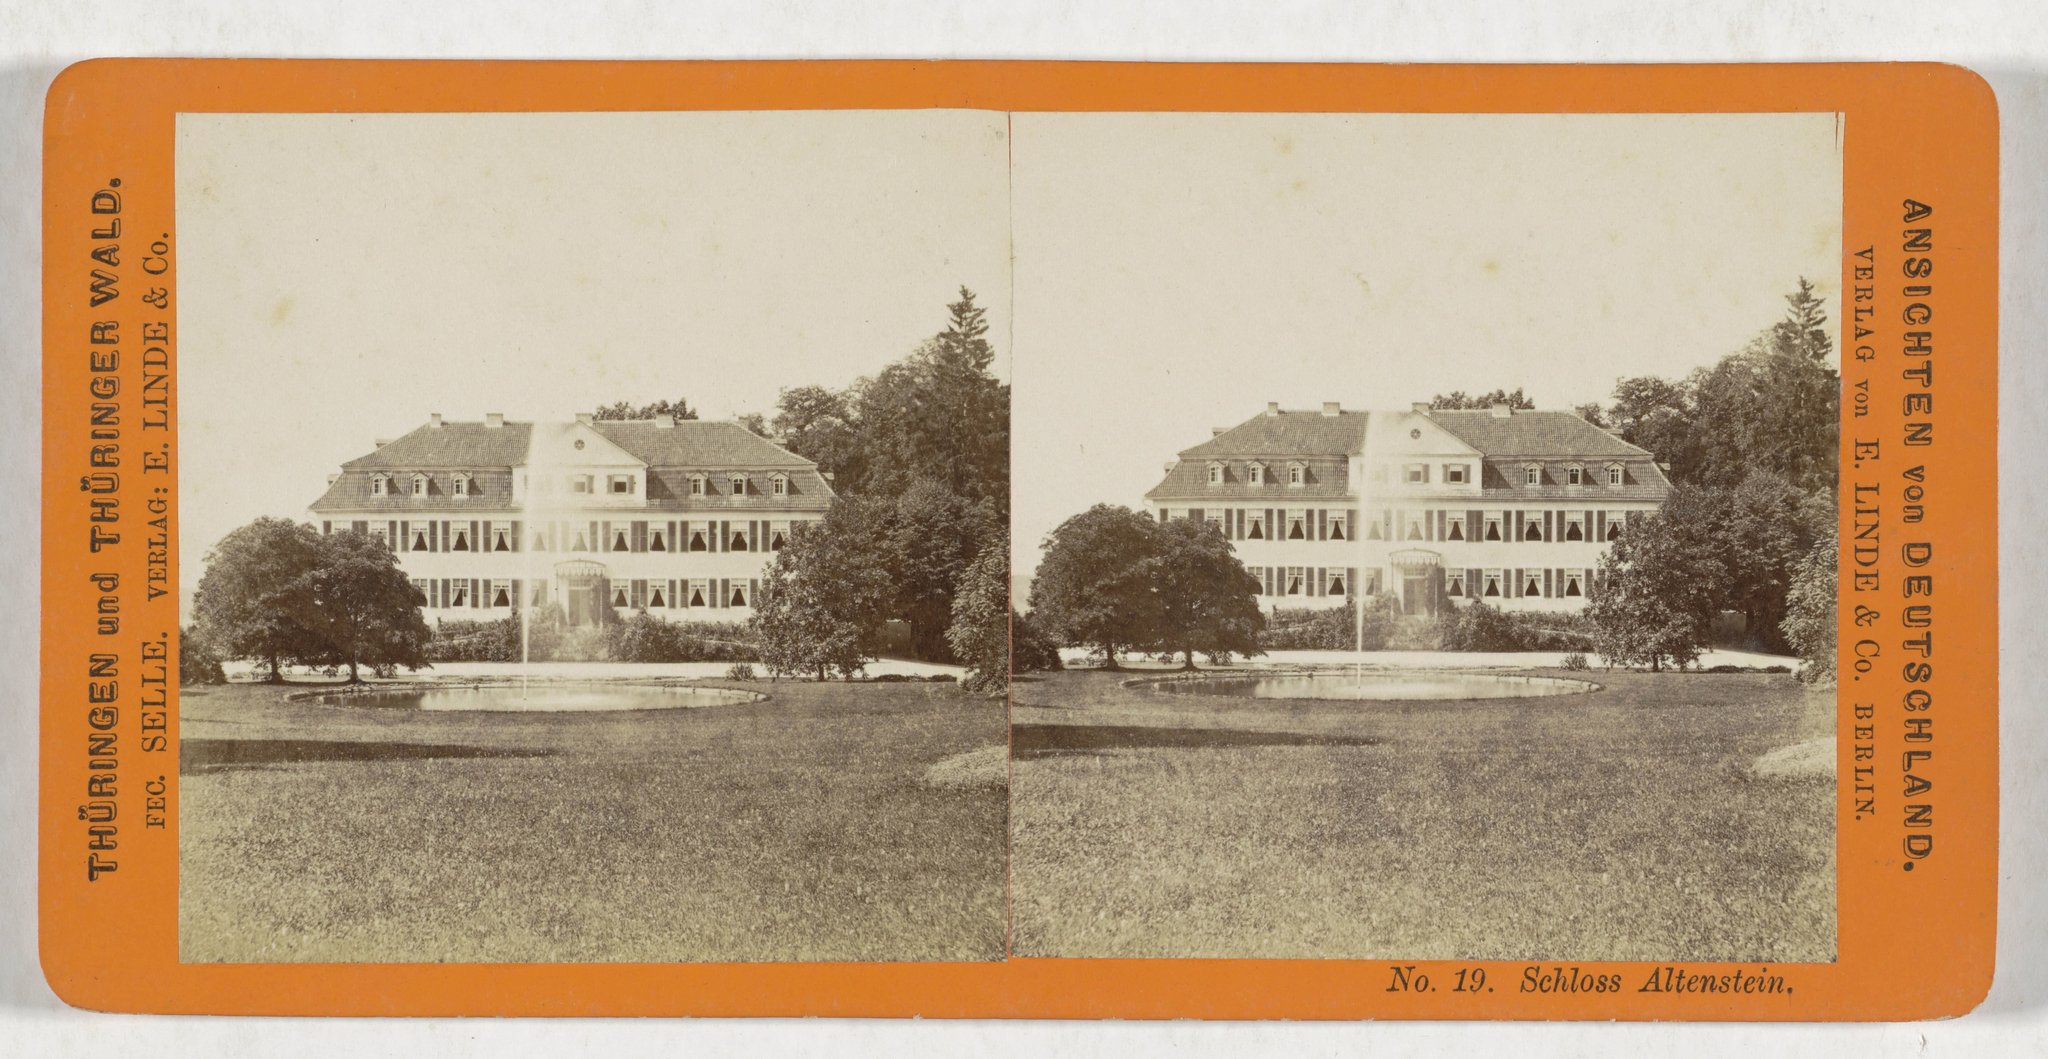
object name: stereograph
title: Schloss Altenstein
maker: hermann selle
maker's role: fotograaf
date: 1868-1890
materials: cardboard, paper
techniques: albumen print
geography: altenstein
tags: garden fountain, palace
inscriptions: number: ‘No. 19.’